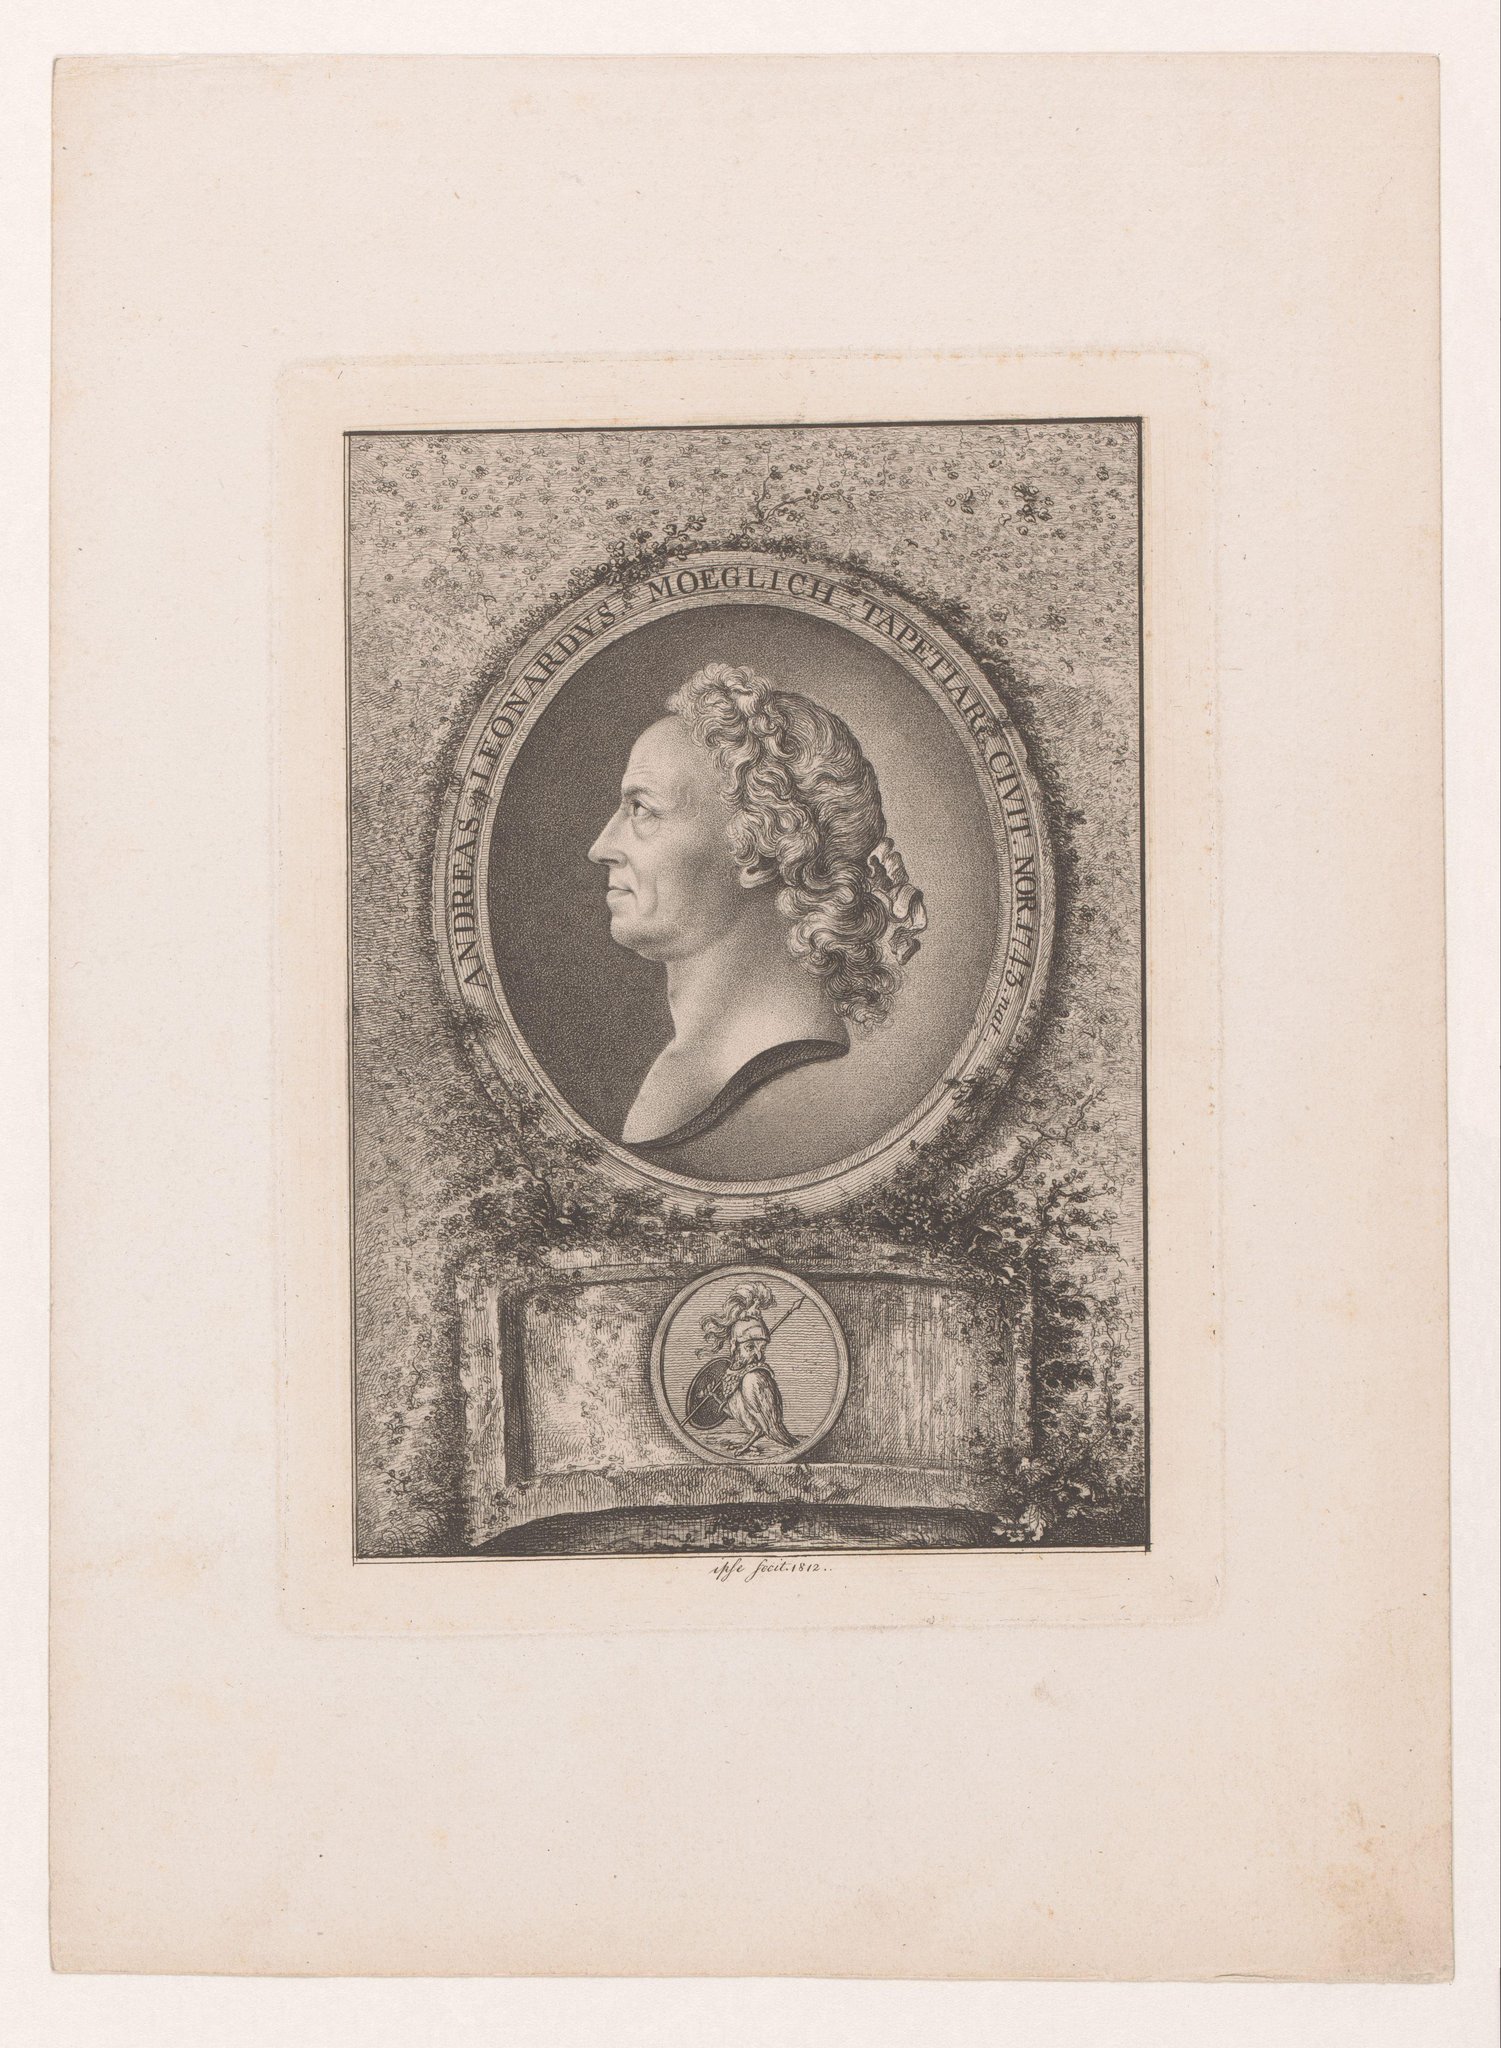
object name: print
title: Portret van Andreas Leohard Moeglich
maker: Anonymous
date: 1812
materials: paper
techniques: etching, engraving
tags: print maker, andreas leonhard moeglich, portrait, self-portrait of artist, attributes of minerva: owl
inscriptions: collector's mark: Lugt 2228